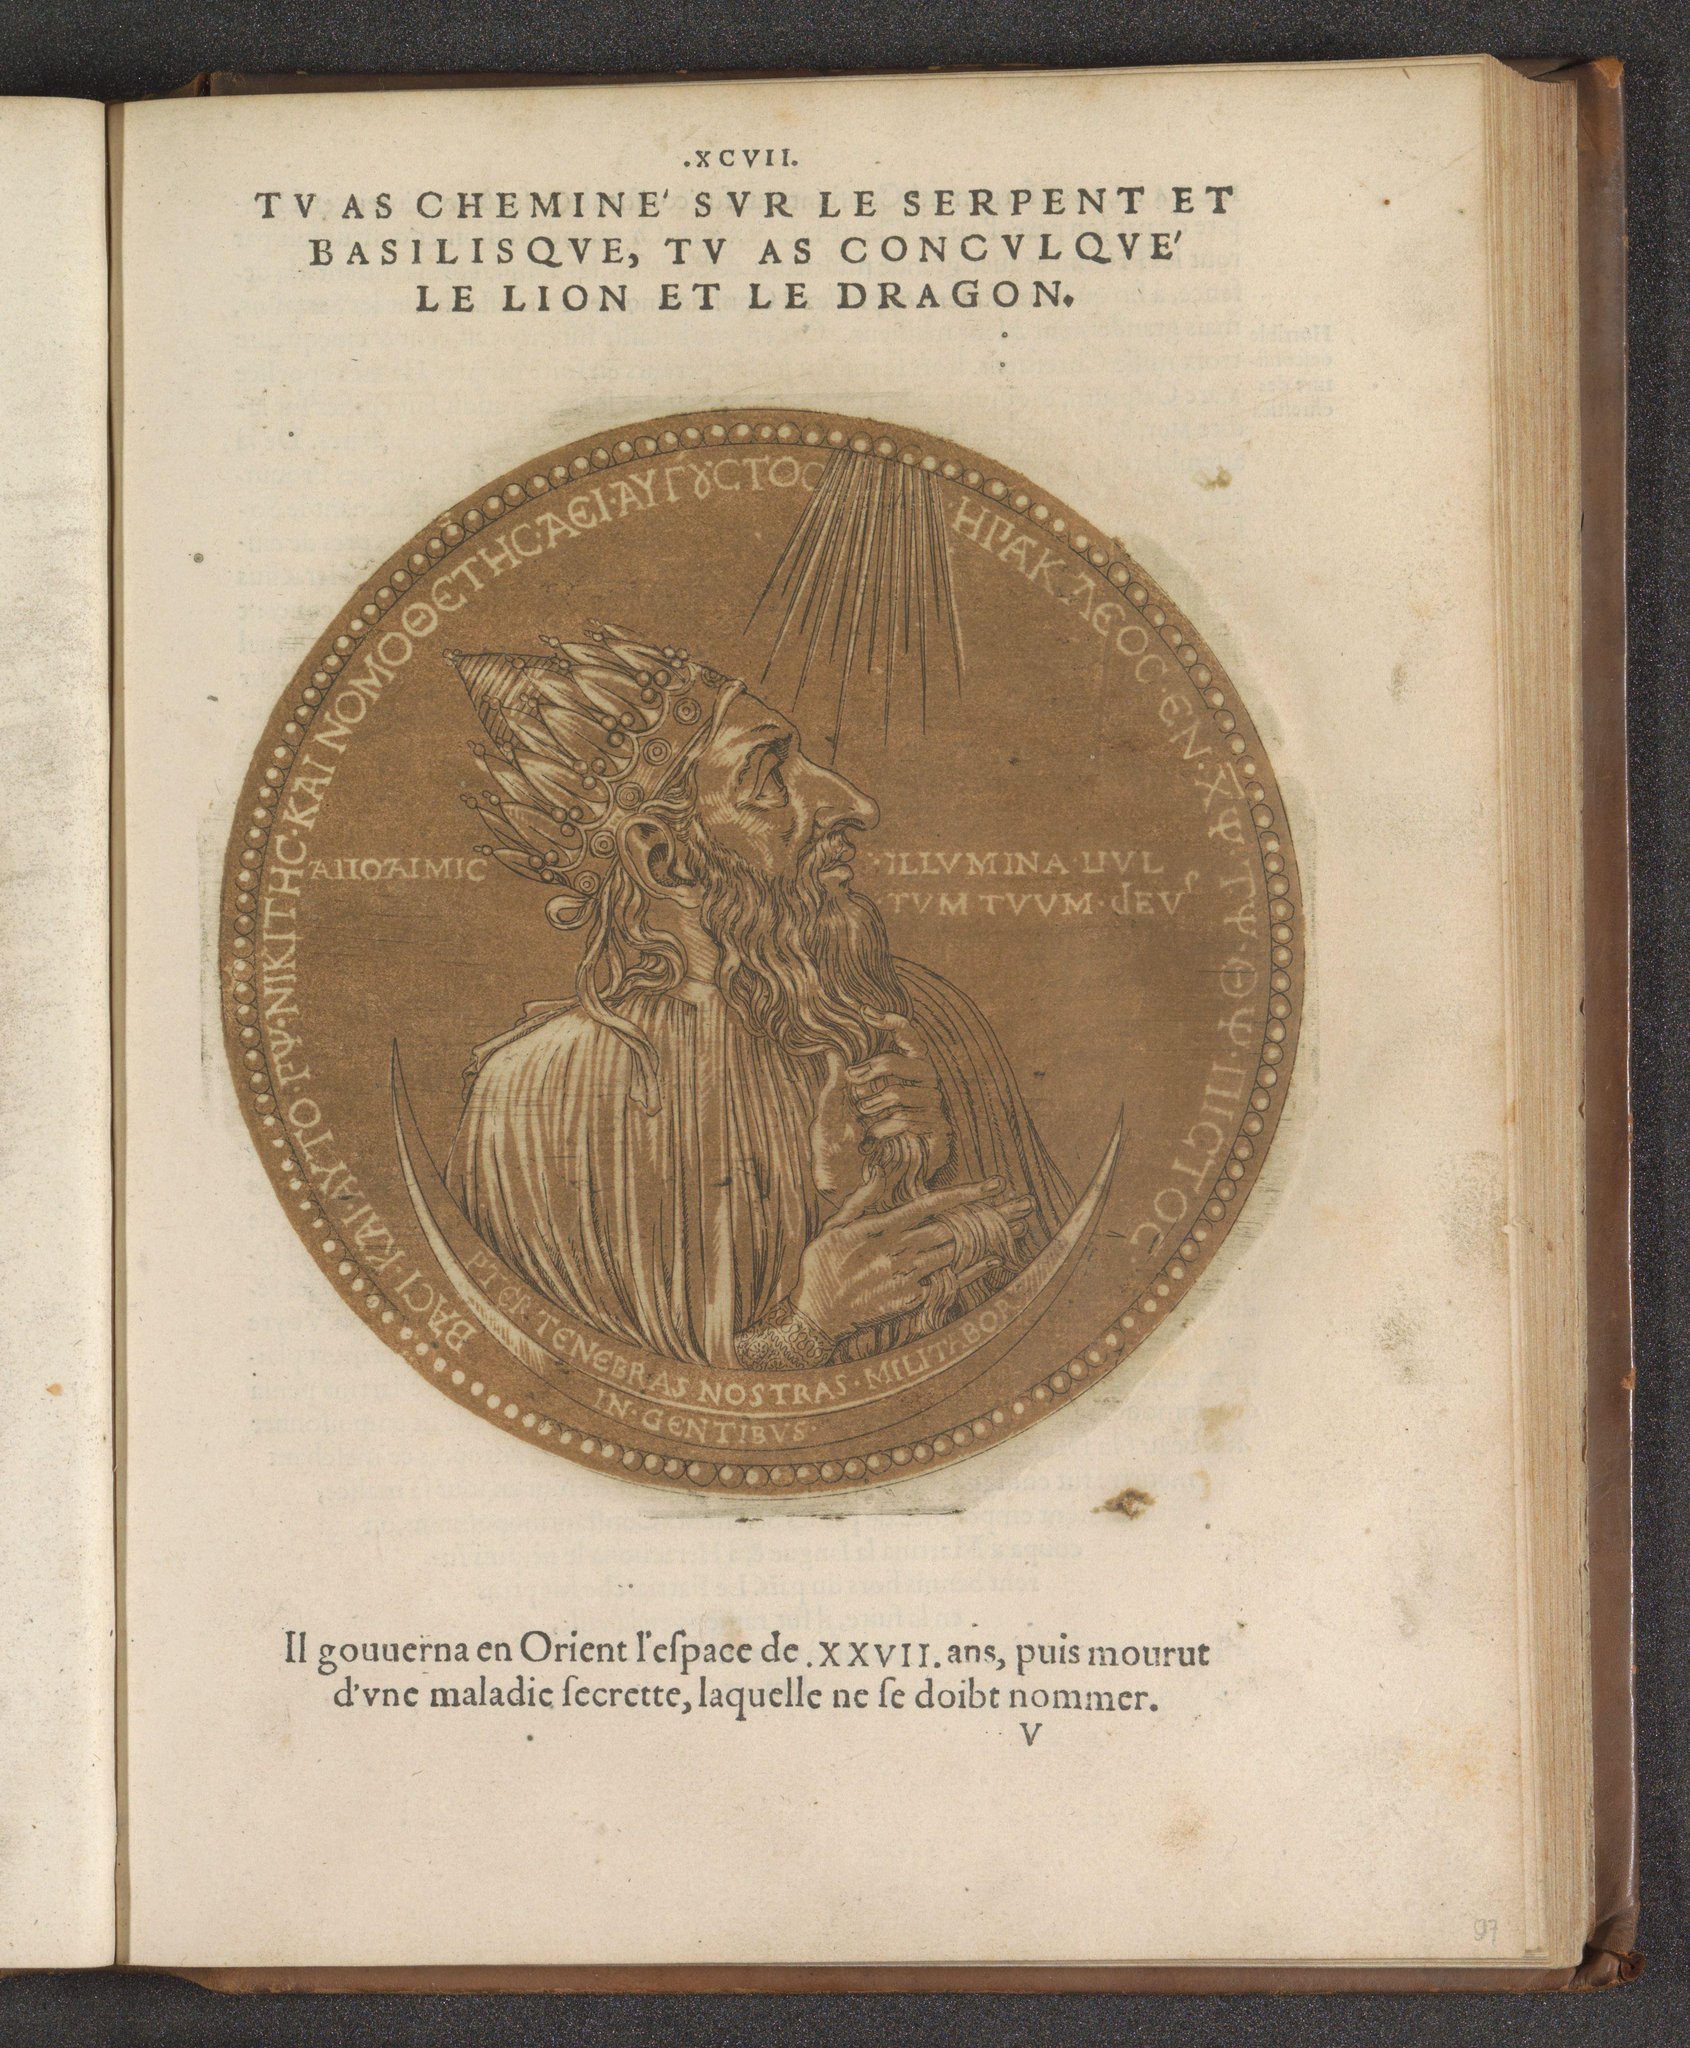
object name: page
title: Portret van keizer Herakleios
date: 1557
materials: paper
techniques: woodcut, etching, letterpress printing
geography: antwerp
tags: emperor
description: Portret van keizer Herakleios, op een munt met randschrift. De prent maakt deel uit van een boek over de keizers vanaf Julius Caesar tot en met Karel V en zijn broer Ferdinand.